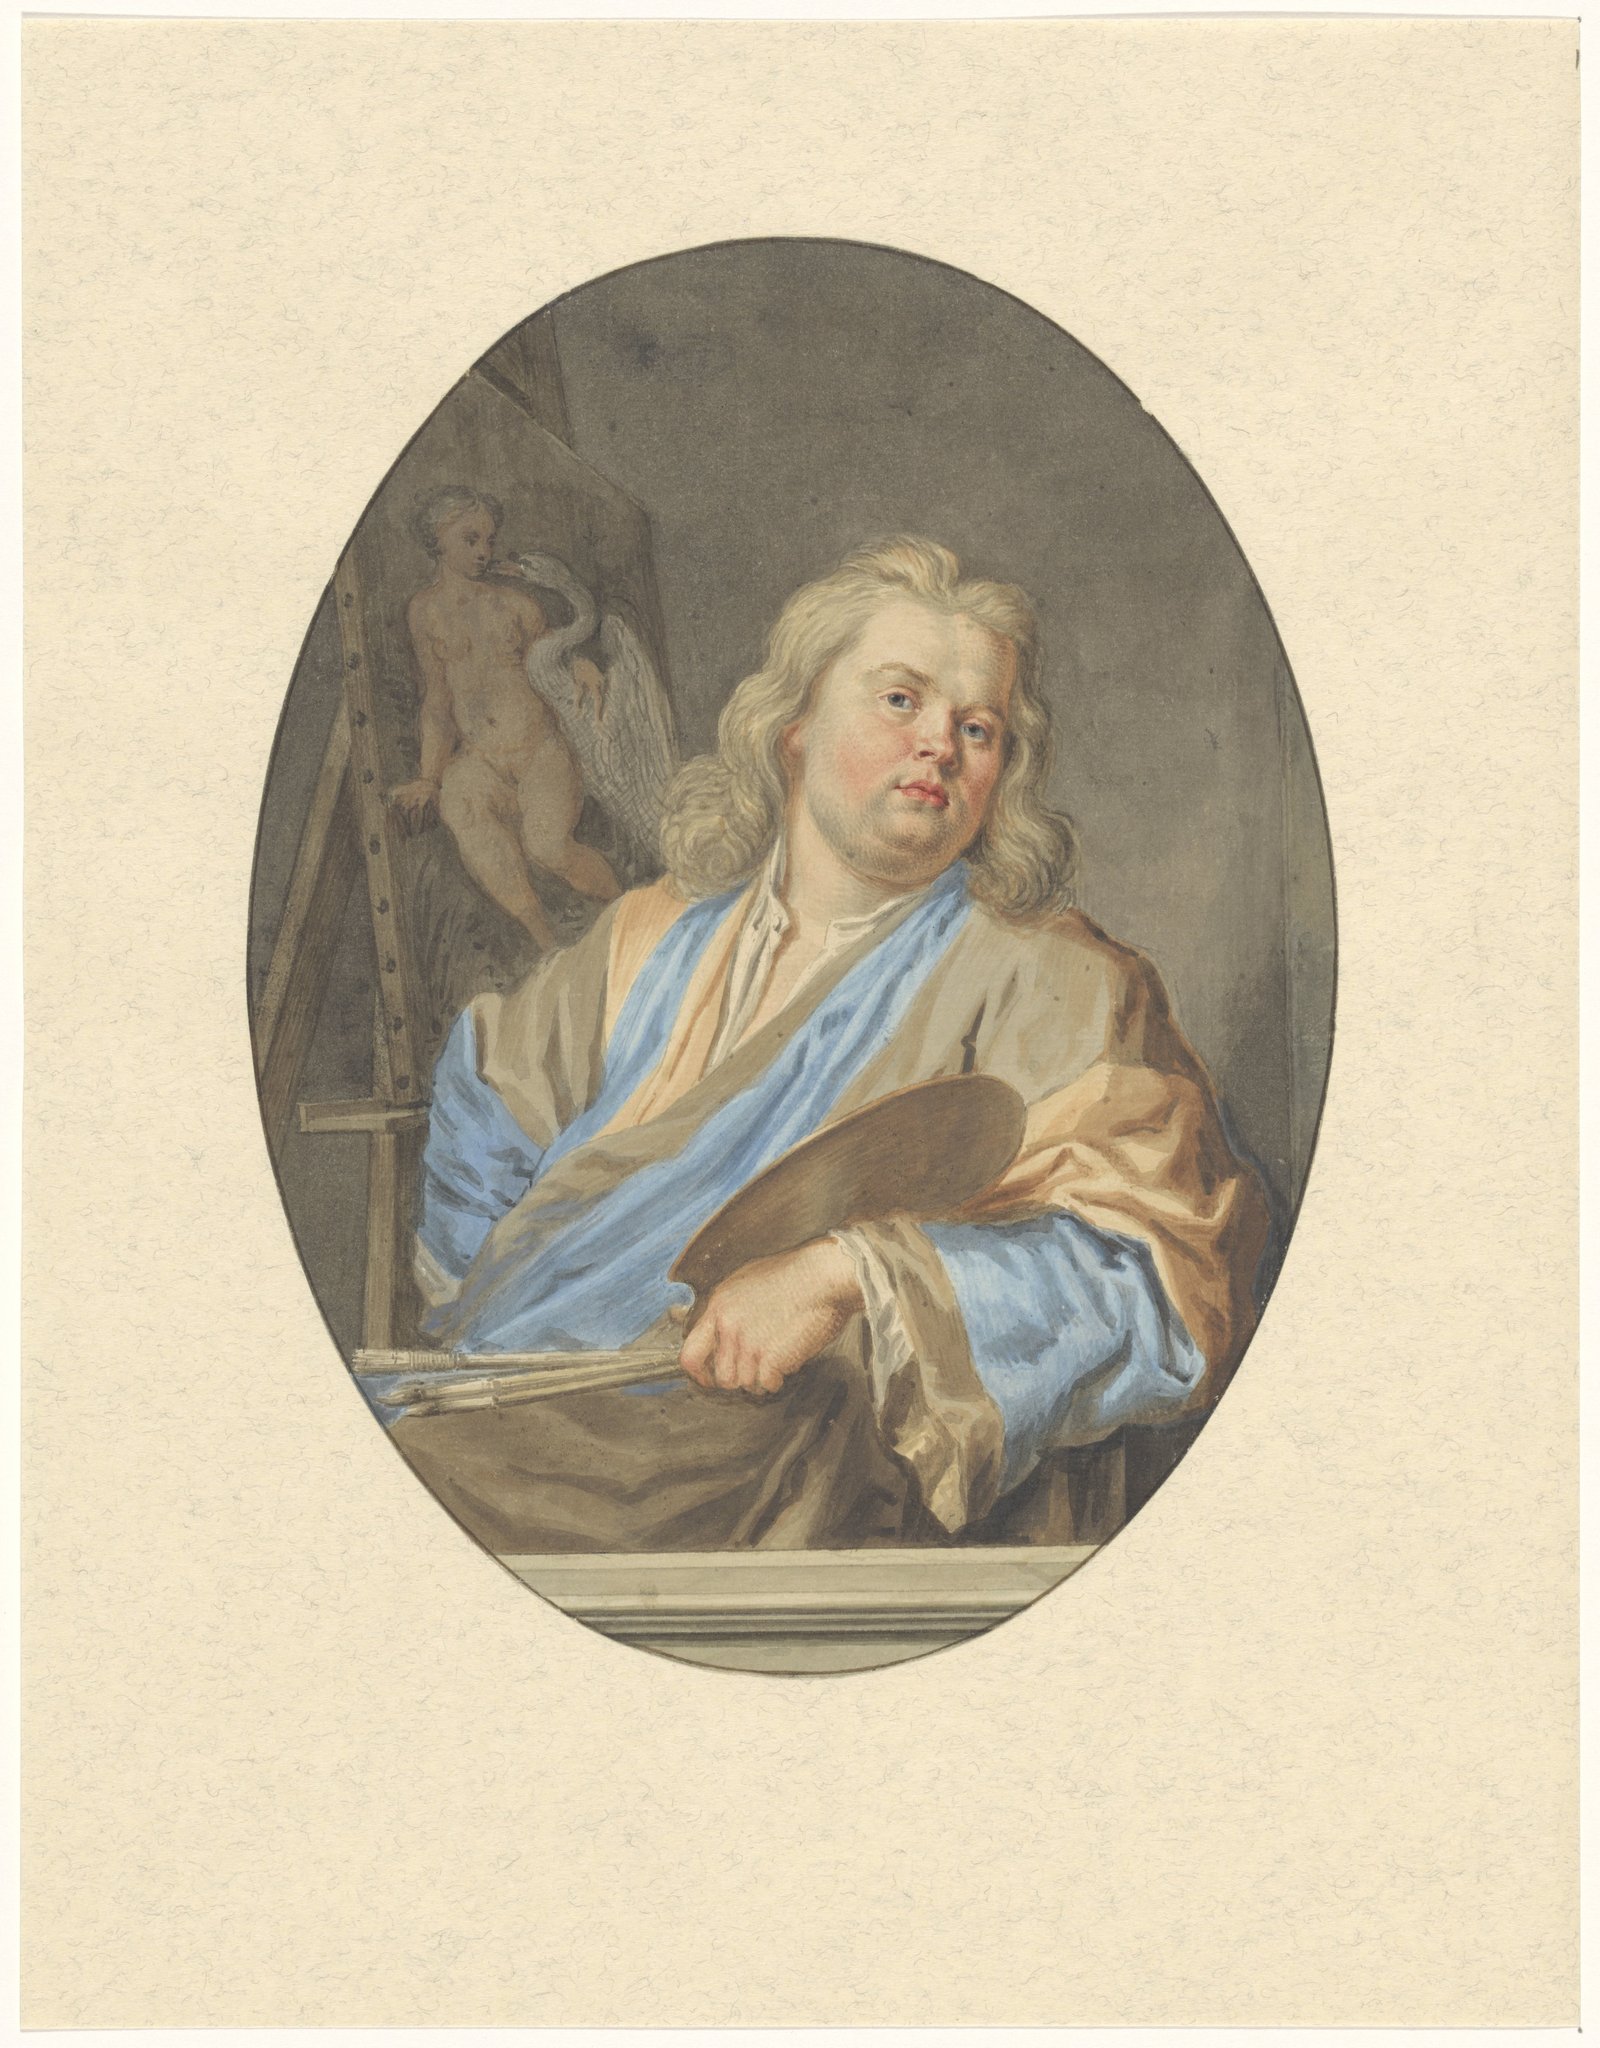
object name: drawing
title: Portret van Nicolaes Six, zittend voor een schilderij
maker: Anonymous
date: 1704-1781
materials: paper, watercolor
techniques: brush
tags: haarlem, print maker, nicolaes six, historical persons, portrait, self-portrait of painter, portrait, self-portrait of artist